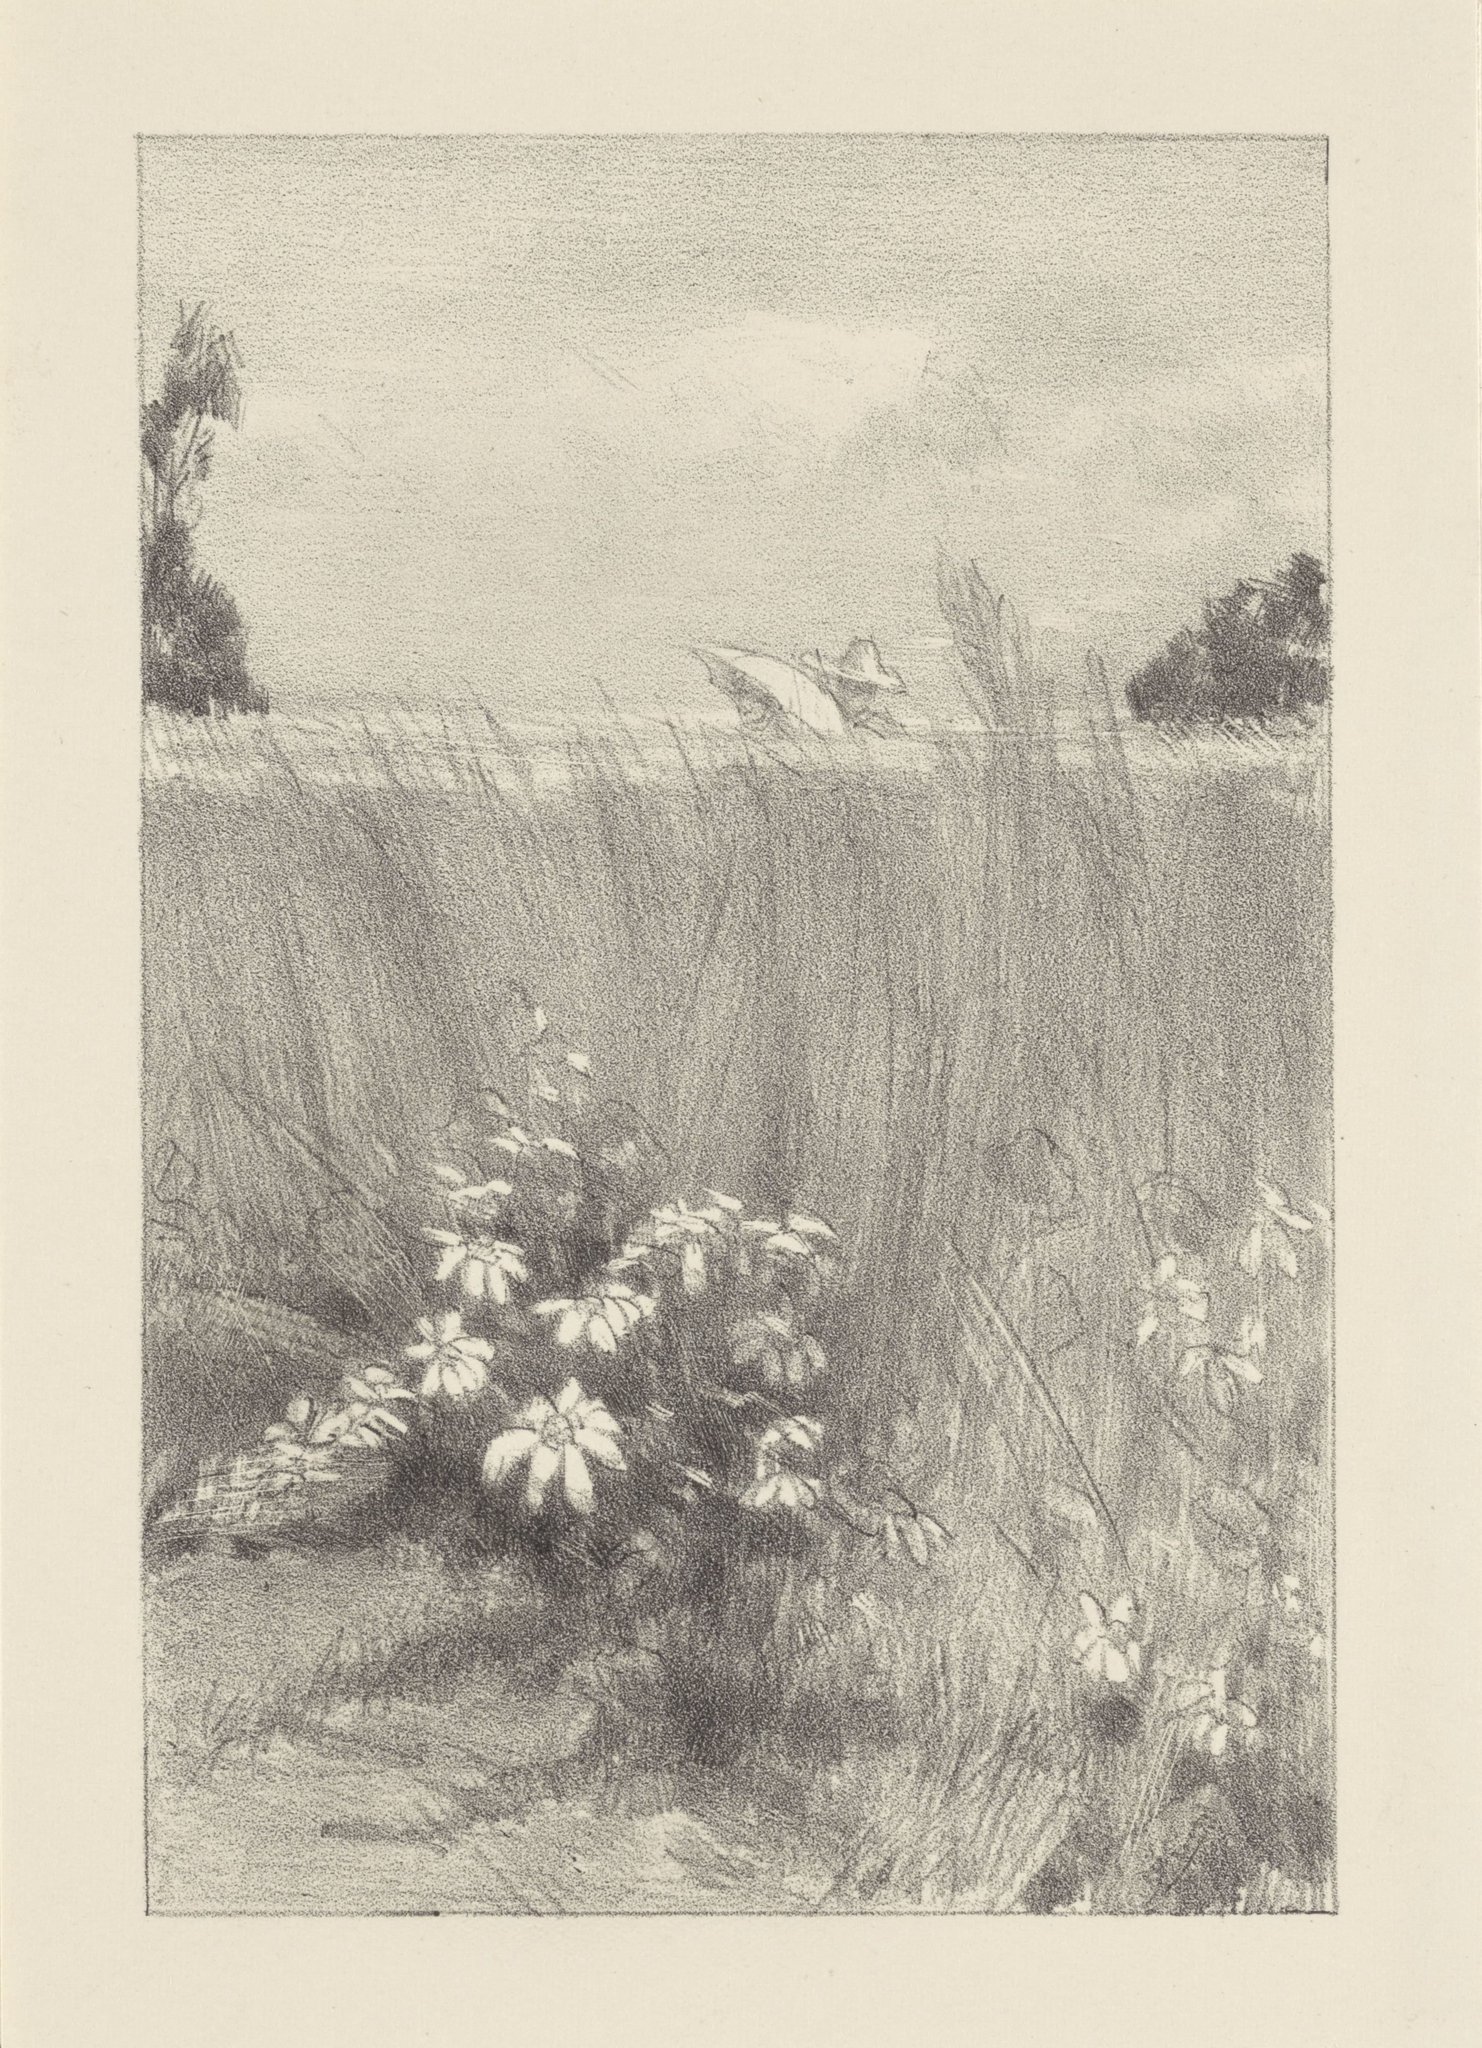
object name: print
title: Korenveld bij Rome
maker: august allebé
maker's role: draughtsman, print maker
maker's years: 1838-1927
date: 1848-1909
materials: paper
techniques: lithography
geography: netherlands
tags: field filled with a crop, umbrella, landscapes (+ landscape with figures, staffage)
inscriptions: collector's mark: Lugt 2228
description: Door een korenveld lopen een man en een vrouw. Hun parasol en hoed steken boven het maaiveld uit.